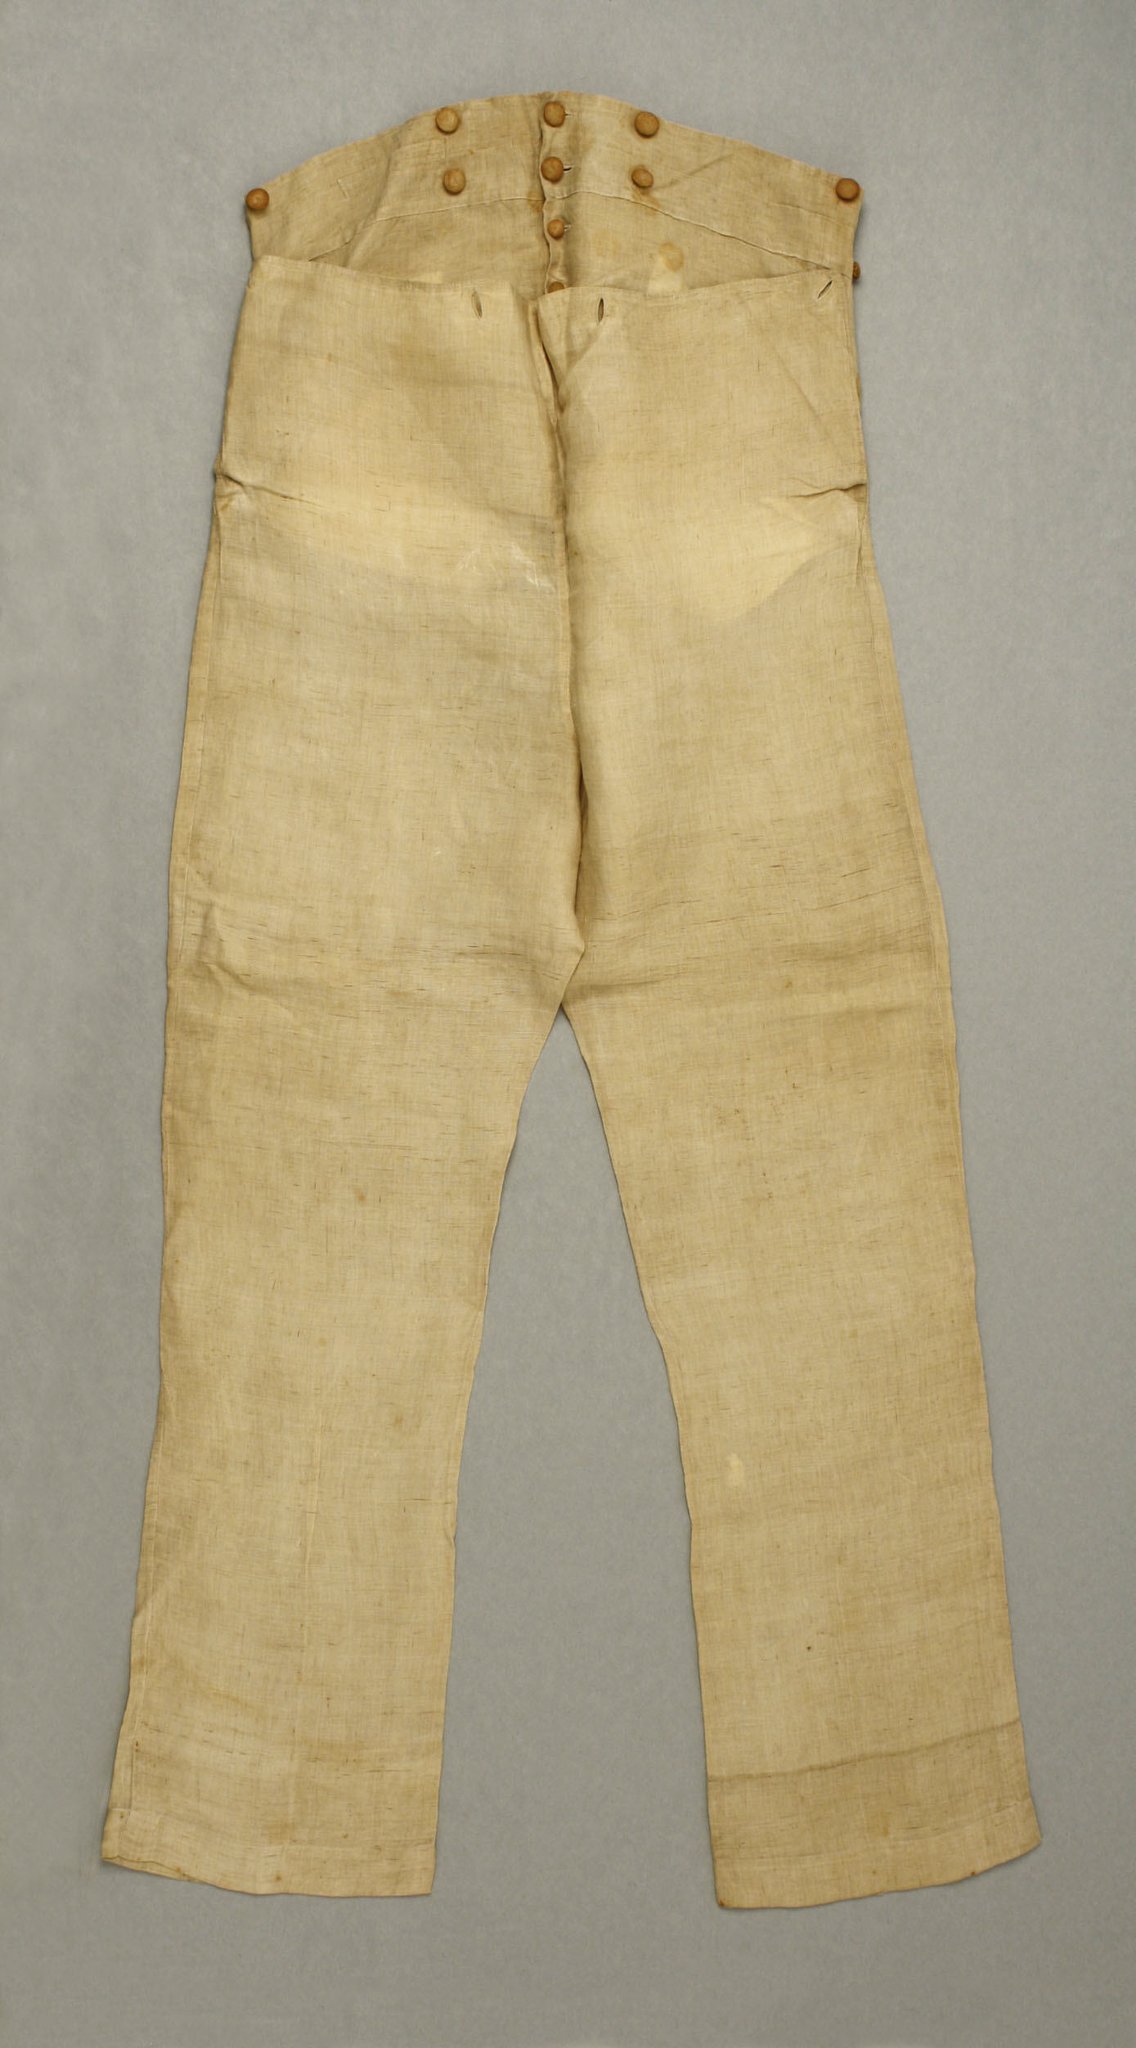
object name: pantaloon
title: Pantaloons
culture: american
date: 1830-1839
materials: linen